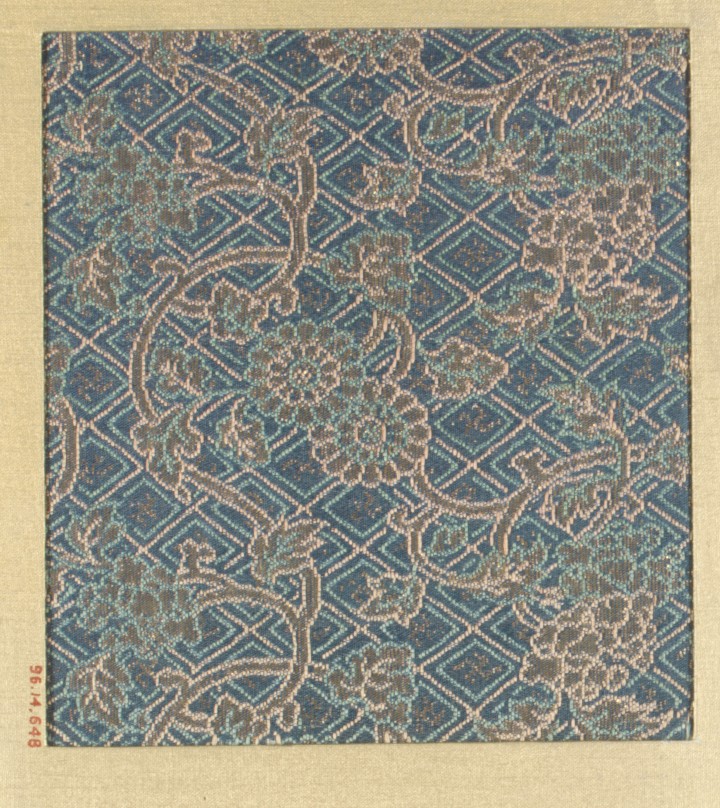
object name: piece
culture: japanese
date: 1701-1900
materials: silk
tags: flowers